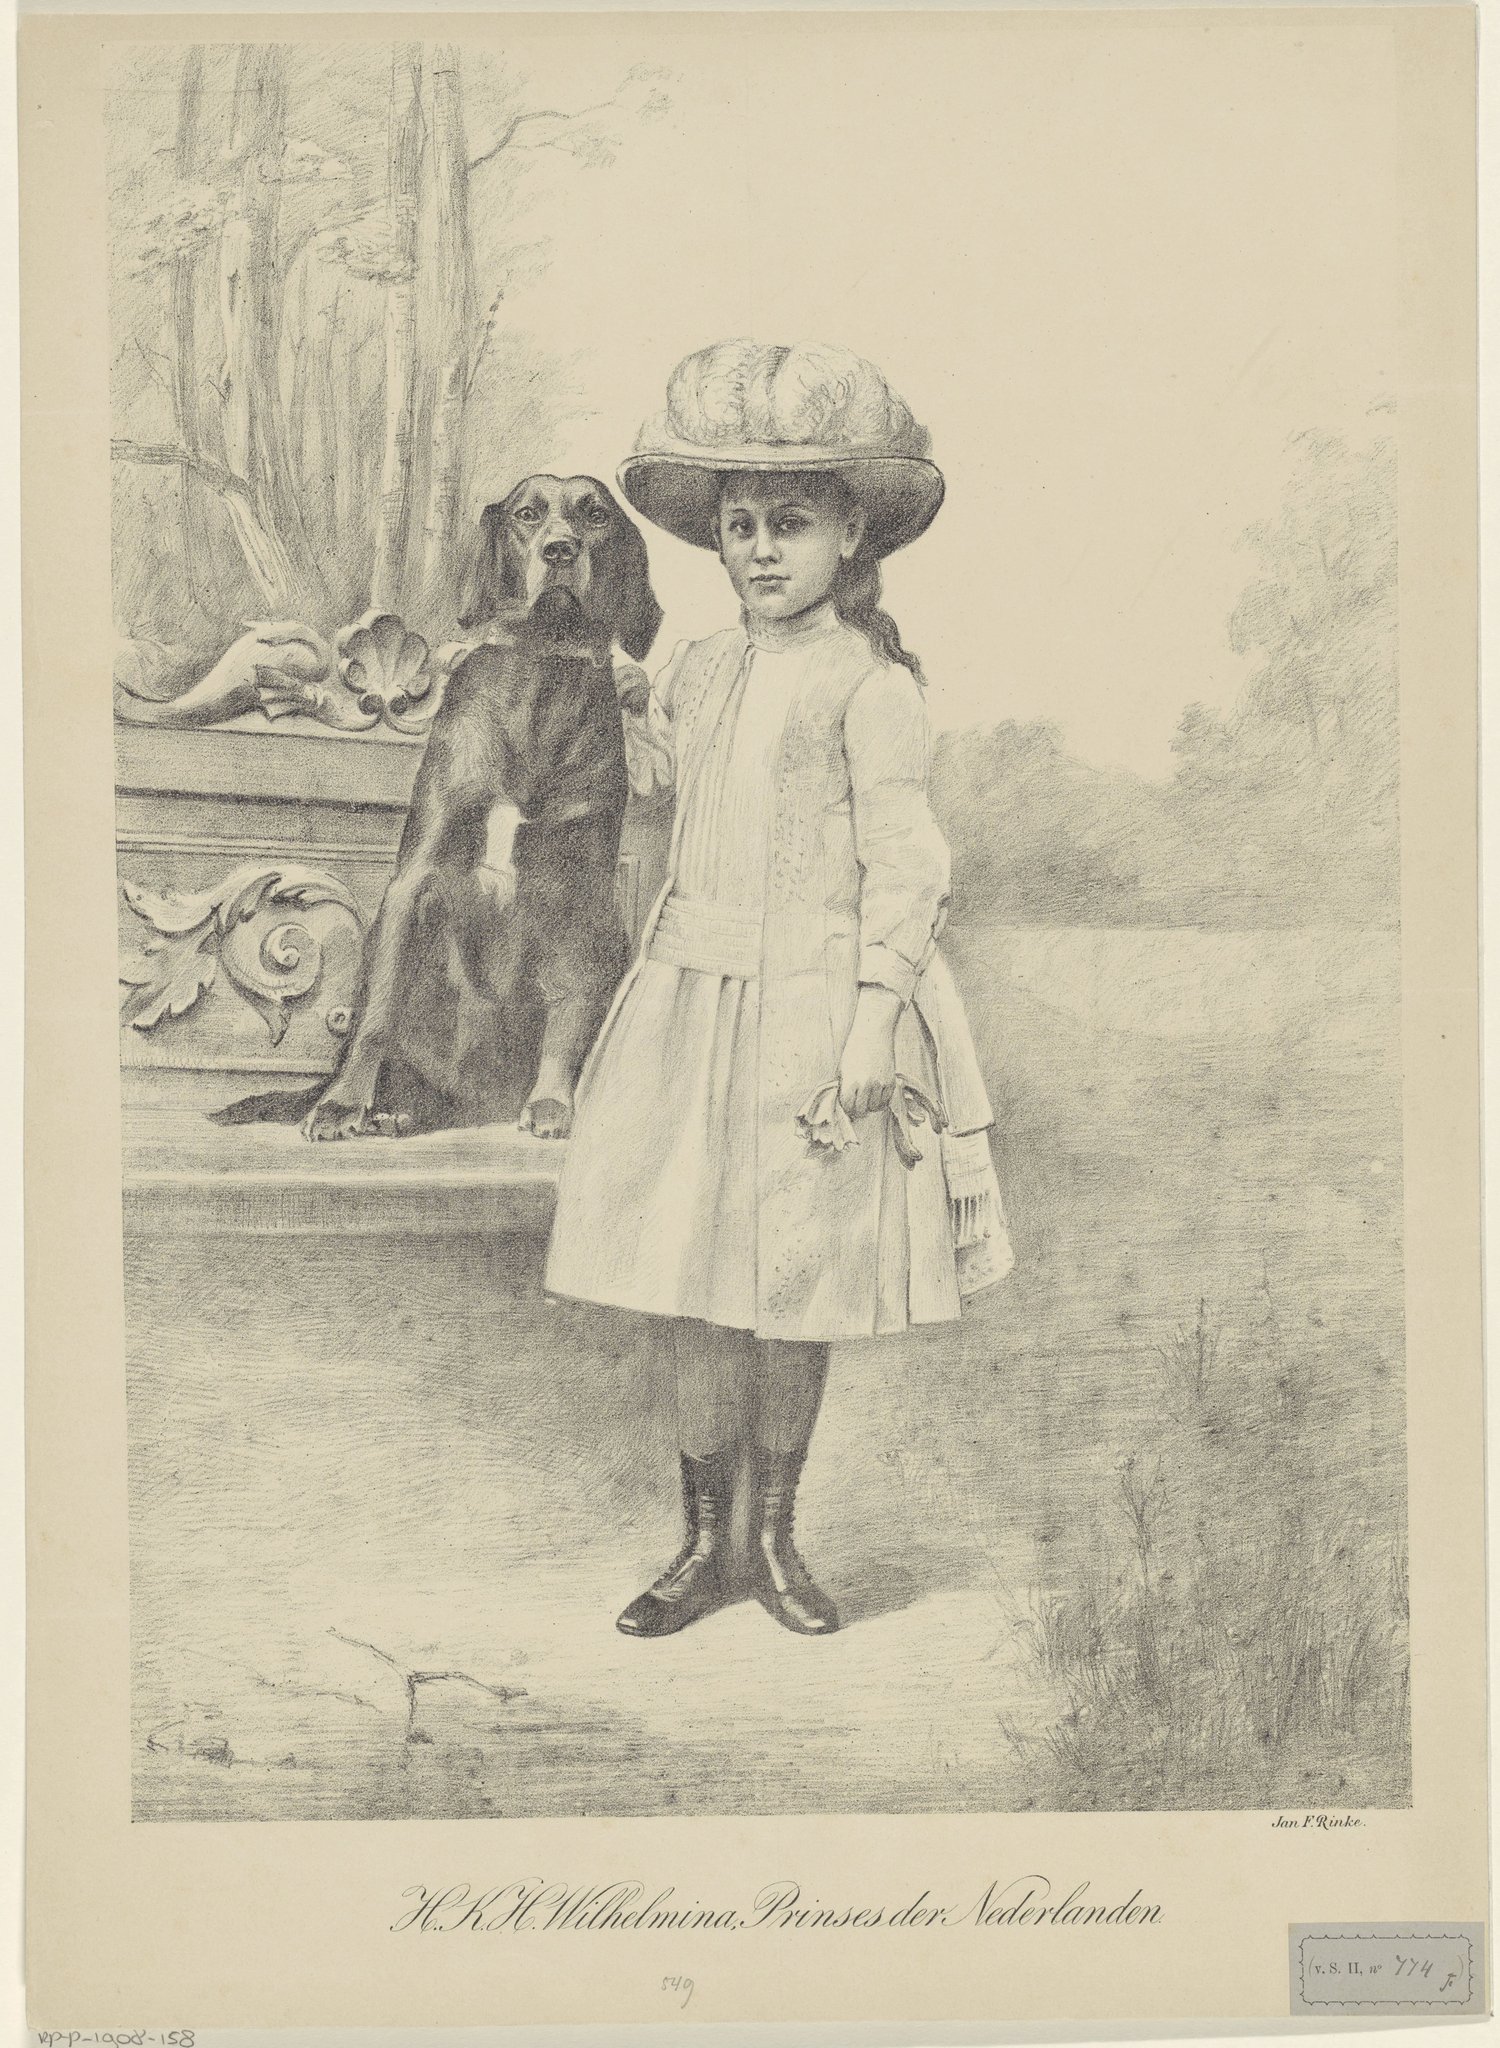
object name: print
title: Portret van Wilhelmina, koningin der Nederlanden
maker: jan rinke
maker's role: painter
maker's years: 1863-1922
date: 1887-1908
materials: paper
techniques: lithograph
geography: netherlands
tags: the hague, print maker, wilhelmina of the netherlands, dog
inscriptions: collector's mark: Lugt 2228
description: De hier vermelde titel verwijst naar de hoogst verkregen titel van de geportretteerde, niet per se naar de titel die de geportretteerde op deze voorstelling draagt.